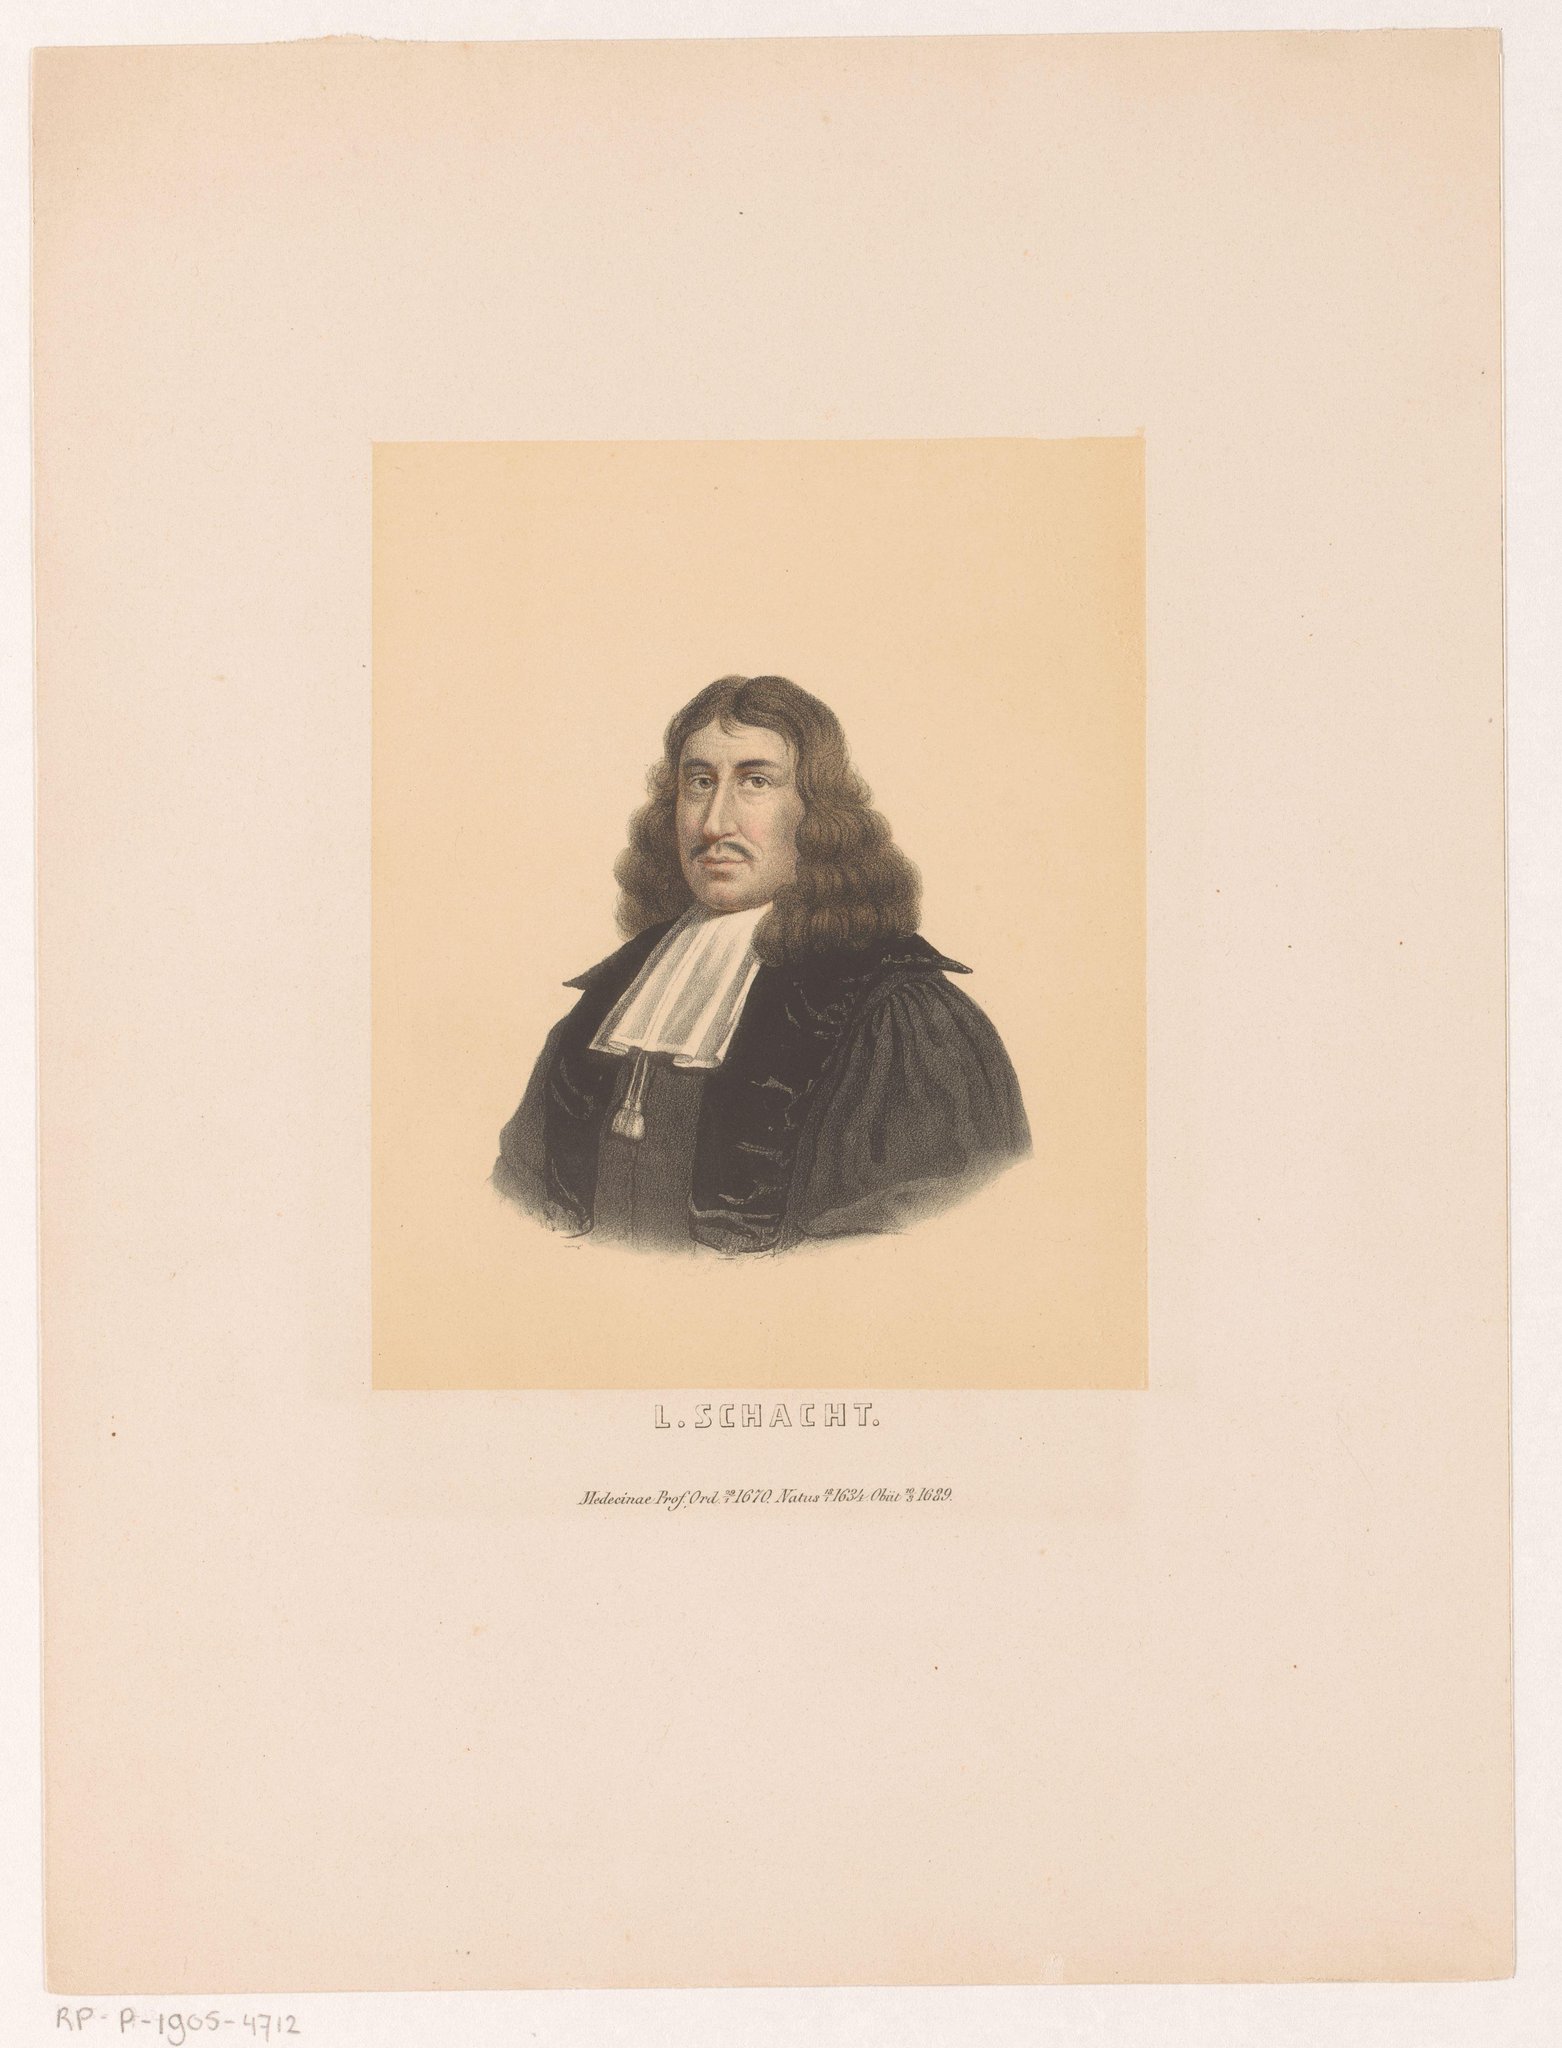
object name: print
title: Portret van Lucas Schacht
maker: leendert springer (i)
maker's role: draughtsman, painter, print maker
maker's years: 1789-1871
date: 1850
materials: paper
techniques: lithograph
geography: leiden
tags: amsterdam, historical persons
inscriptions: collector's mark: Lugt 2228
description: Prent uit: Springer, Leendert. Galerij van hoogleeraren aan de Hoogeschool te Leijden, naar de oorspronkelijke afbeeldsels op de Senaat-zaal aldaar berustende. Leiden: Springer, Leendert., s.a. [circa 1850].